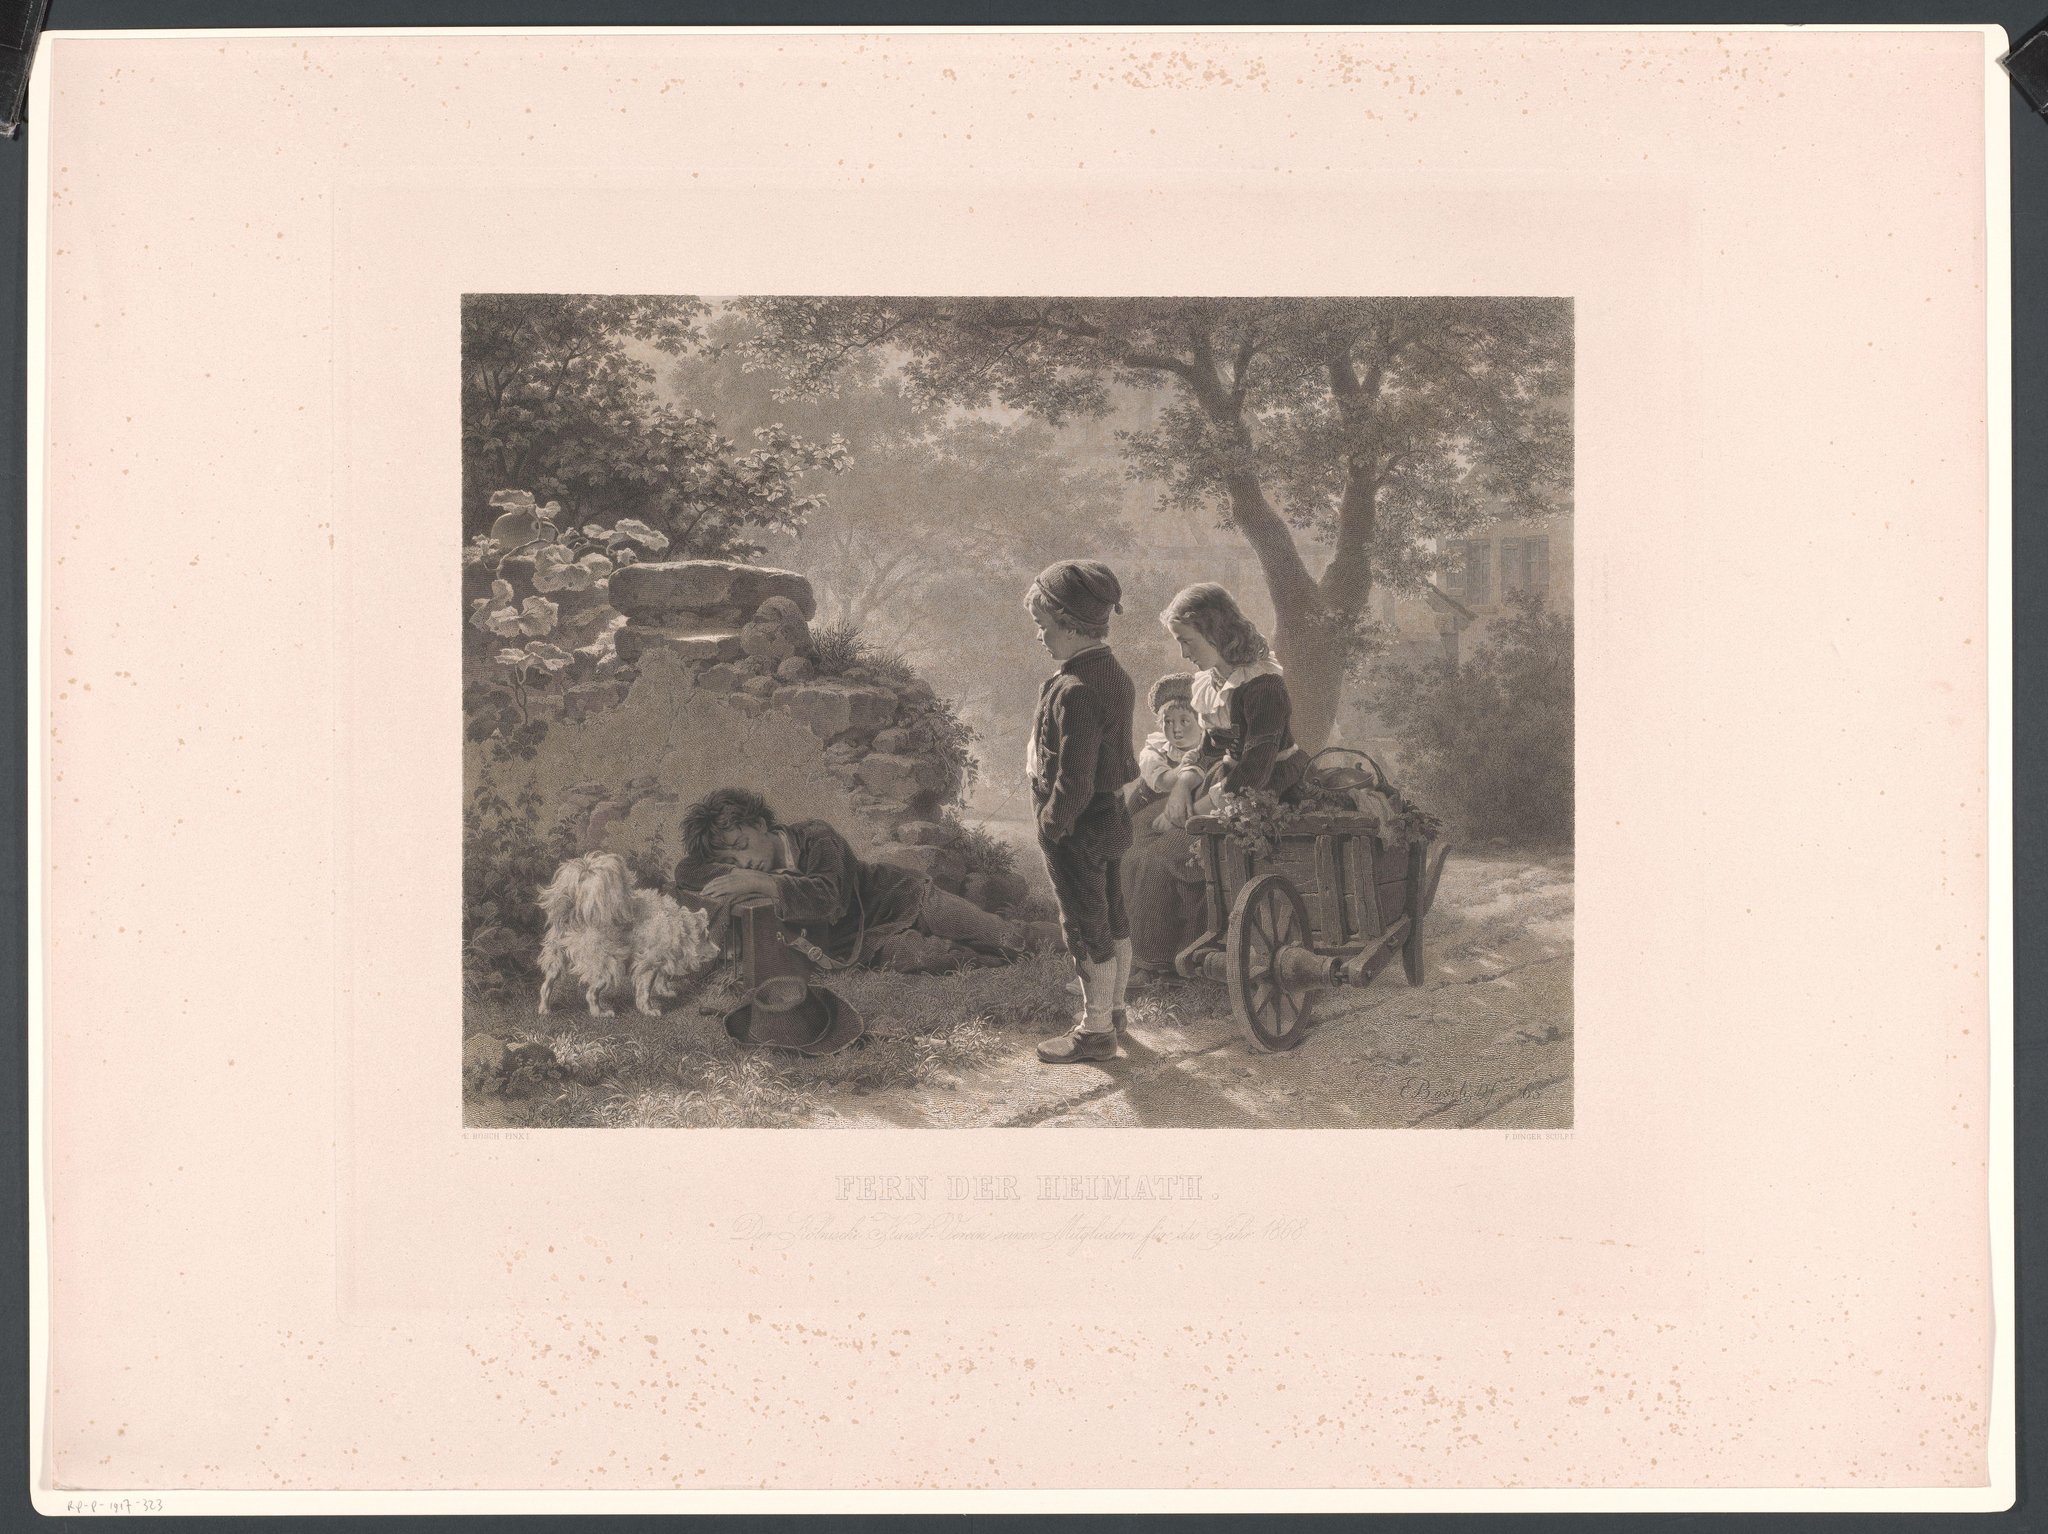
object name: print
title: Fern der Heimath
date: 1865-1904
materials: paper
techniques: engraving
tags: child, sleeping on the ground - bb - out of doors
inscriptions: collector's mark: Lugt 2228